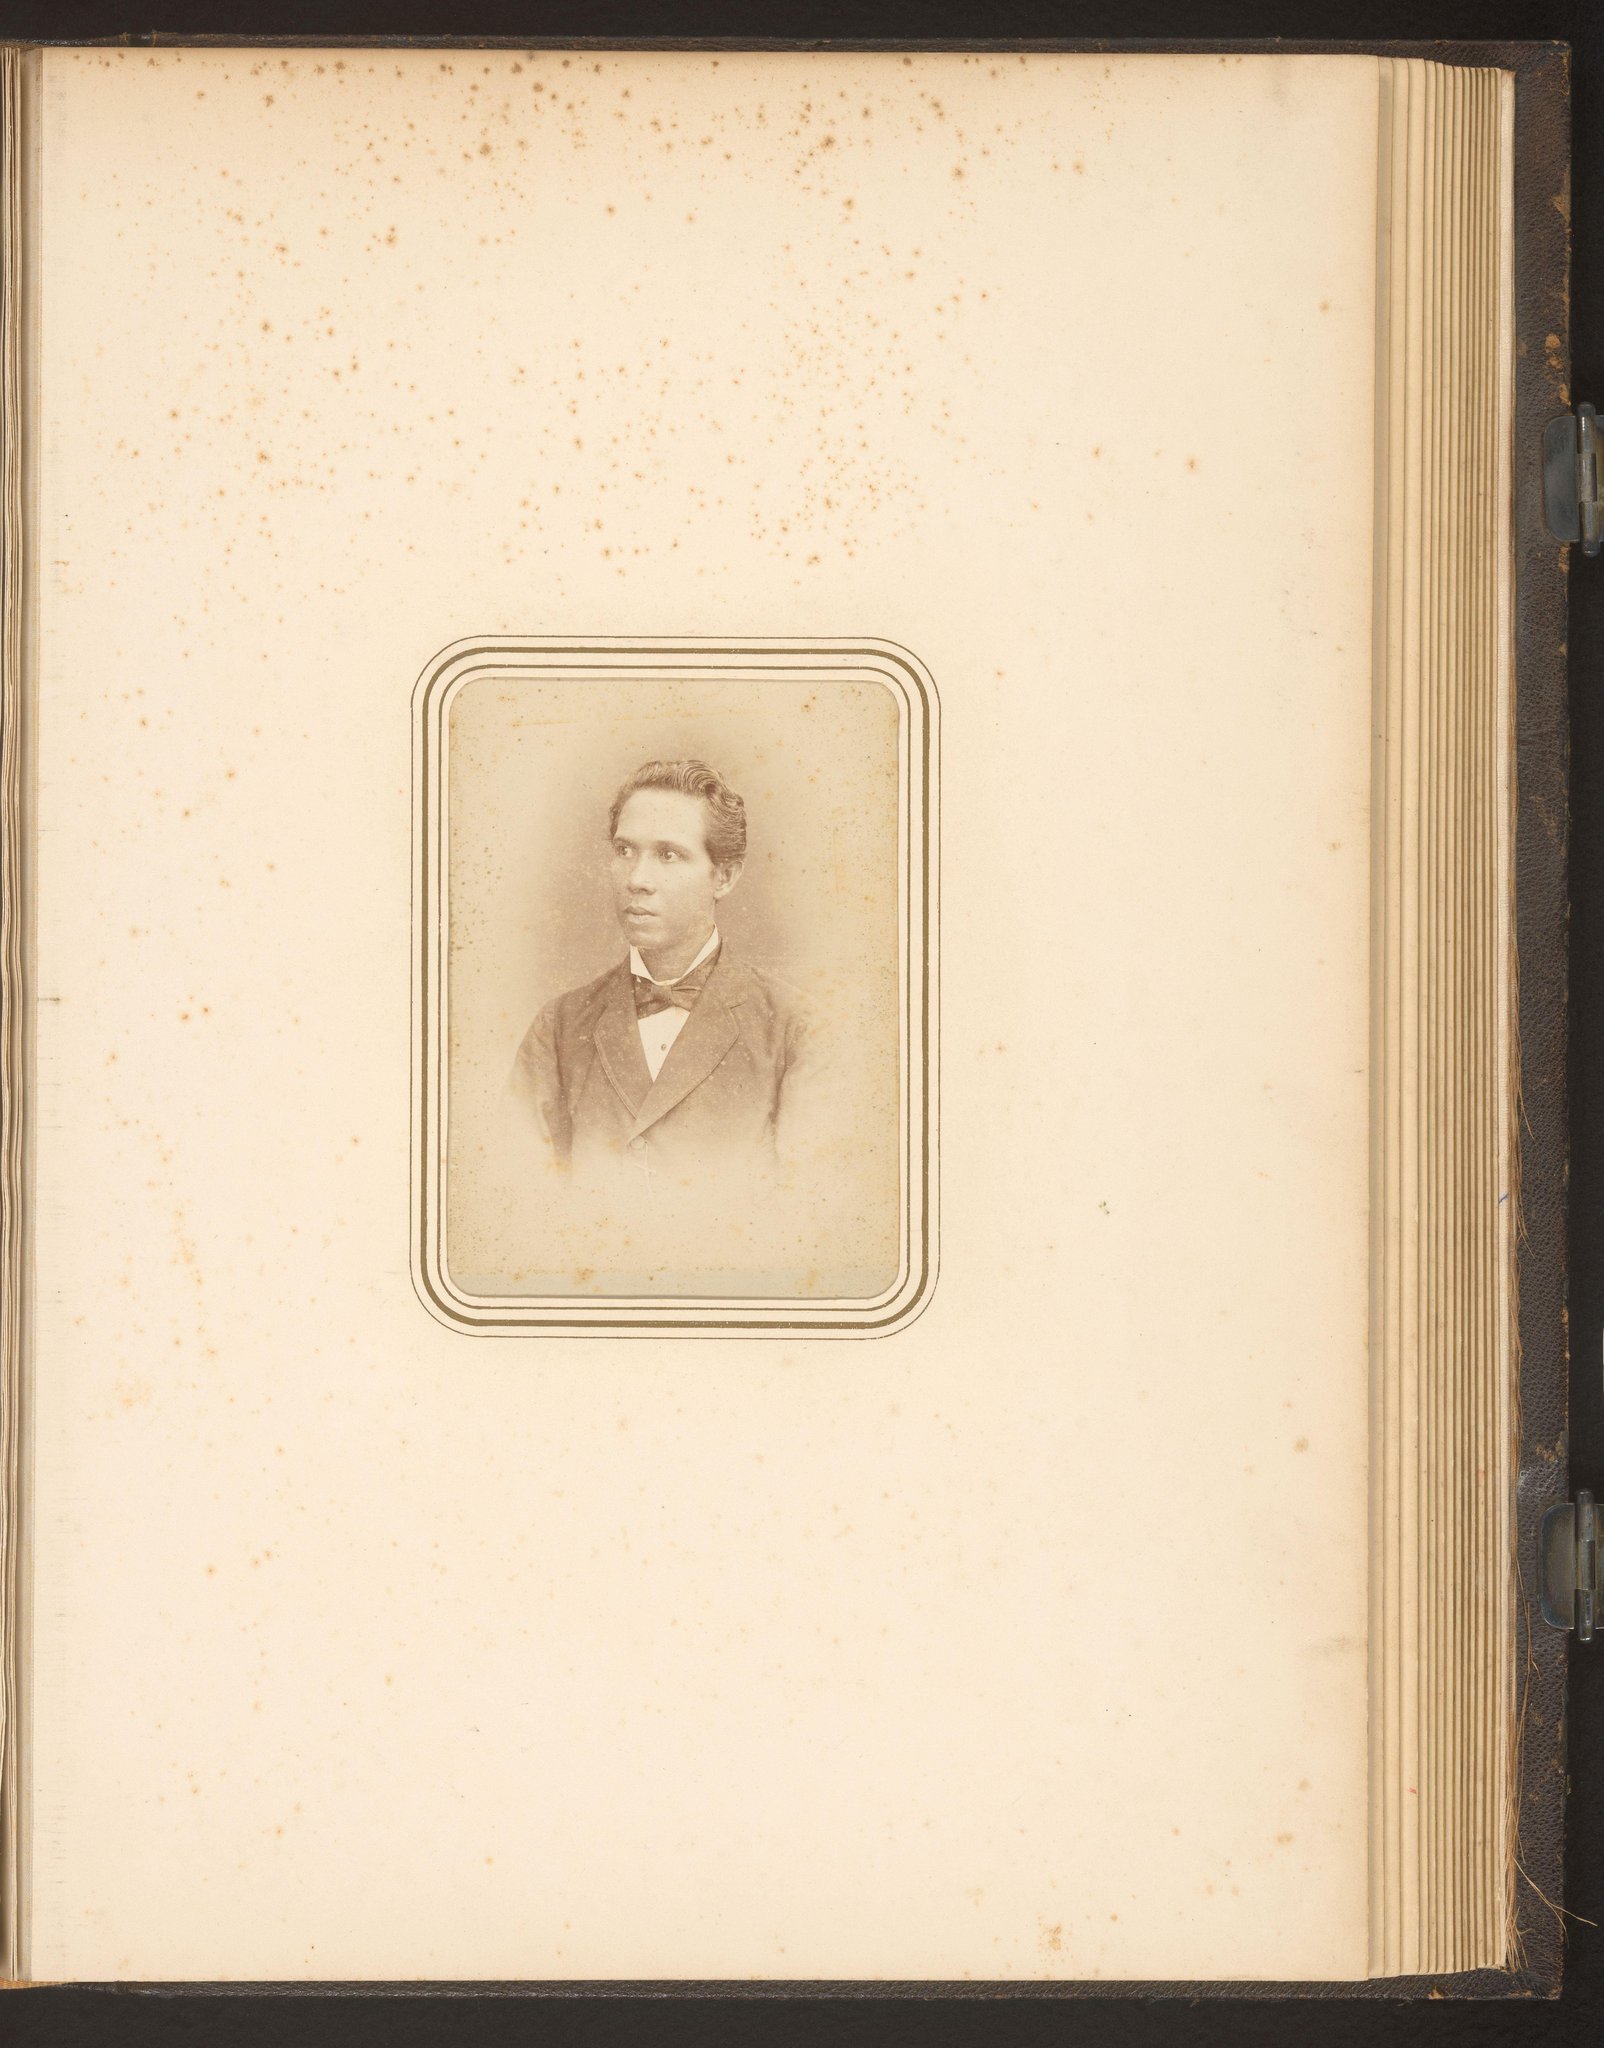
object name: cabinet photograph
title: Portret van onbekende man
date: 1882-1887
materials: cardboard, photographic support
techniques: albumen print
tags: historical persons not known by name, sumatra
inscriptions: name: ‘G.R. Lambert & Co. Photographers by appointment to H.M. the King of Siam and to H.H. the Maharajah of Johore’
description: Portret van een onbekende man. Ingestoken foto in het herinneringsalbum aangeboden door de Tabak Maatschappij Arendsburg aan hoofdadministrateur M.J. Tiele bij zijn terugkeer naar Nederland in 1887.